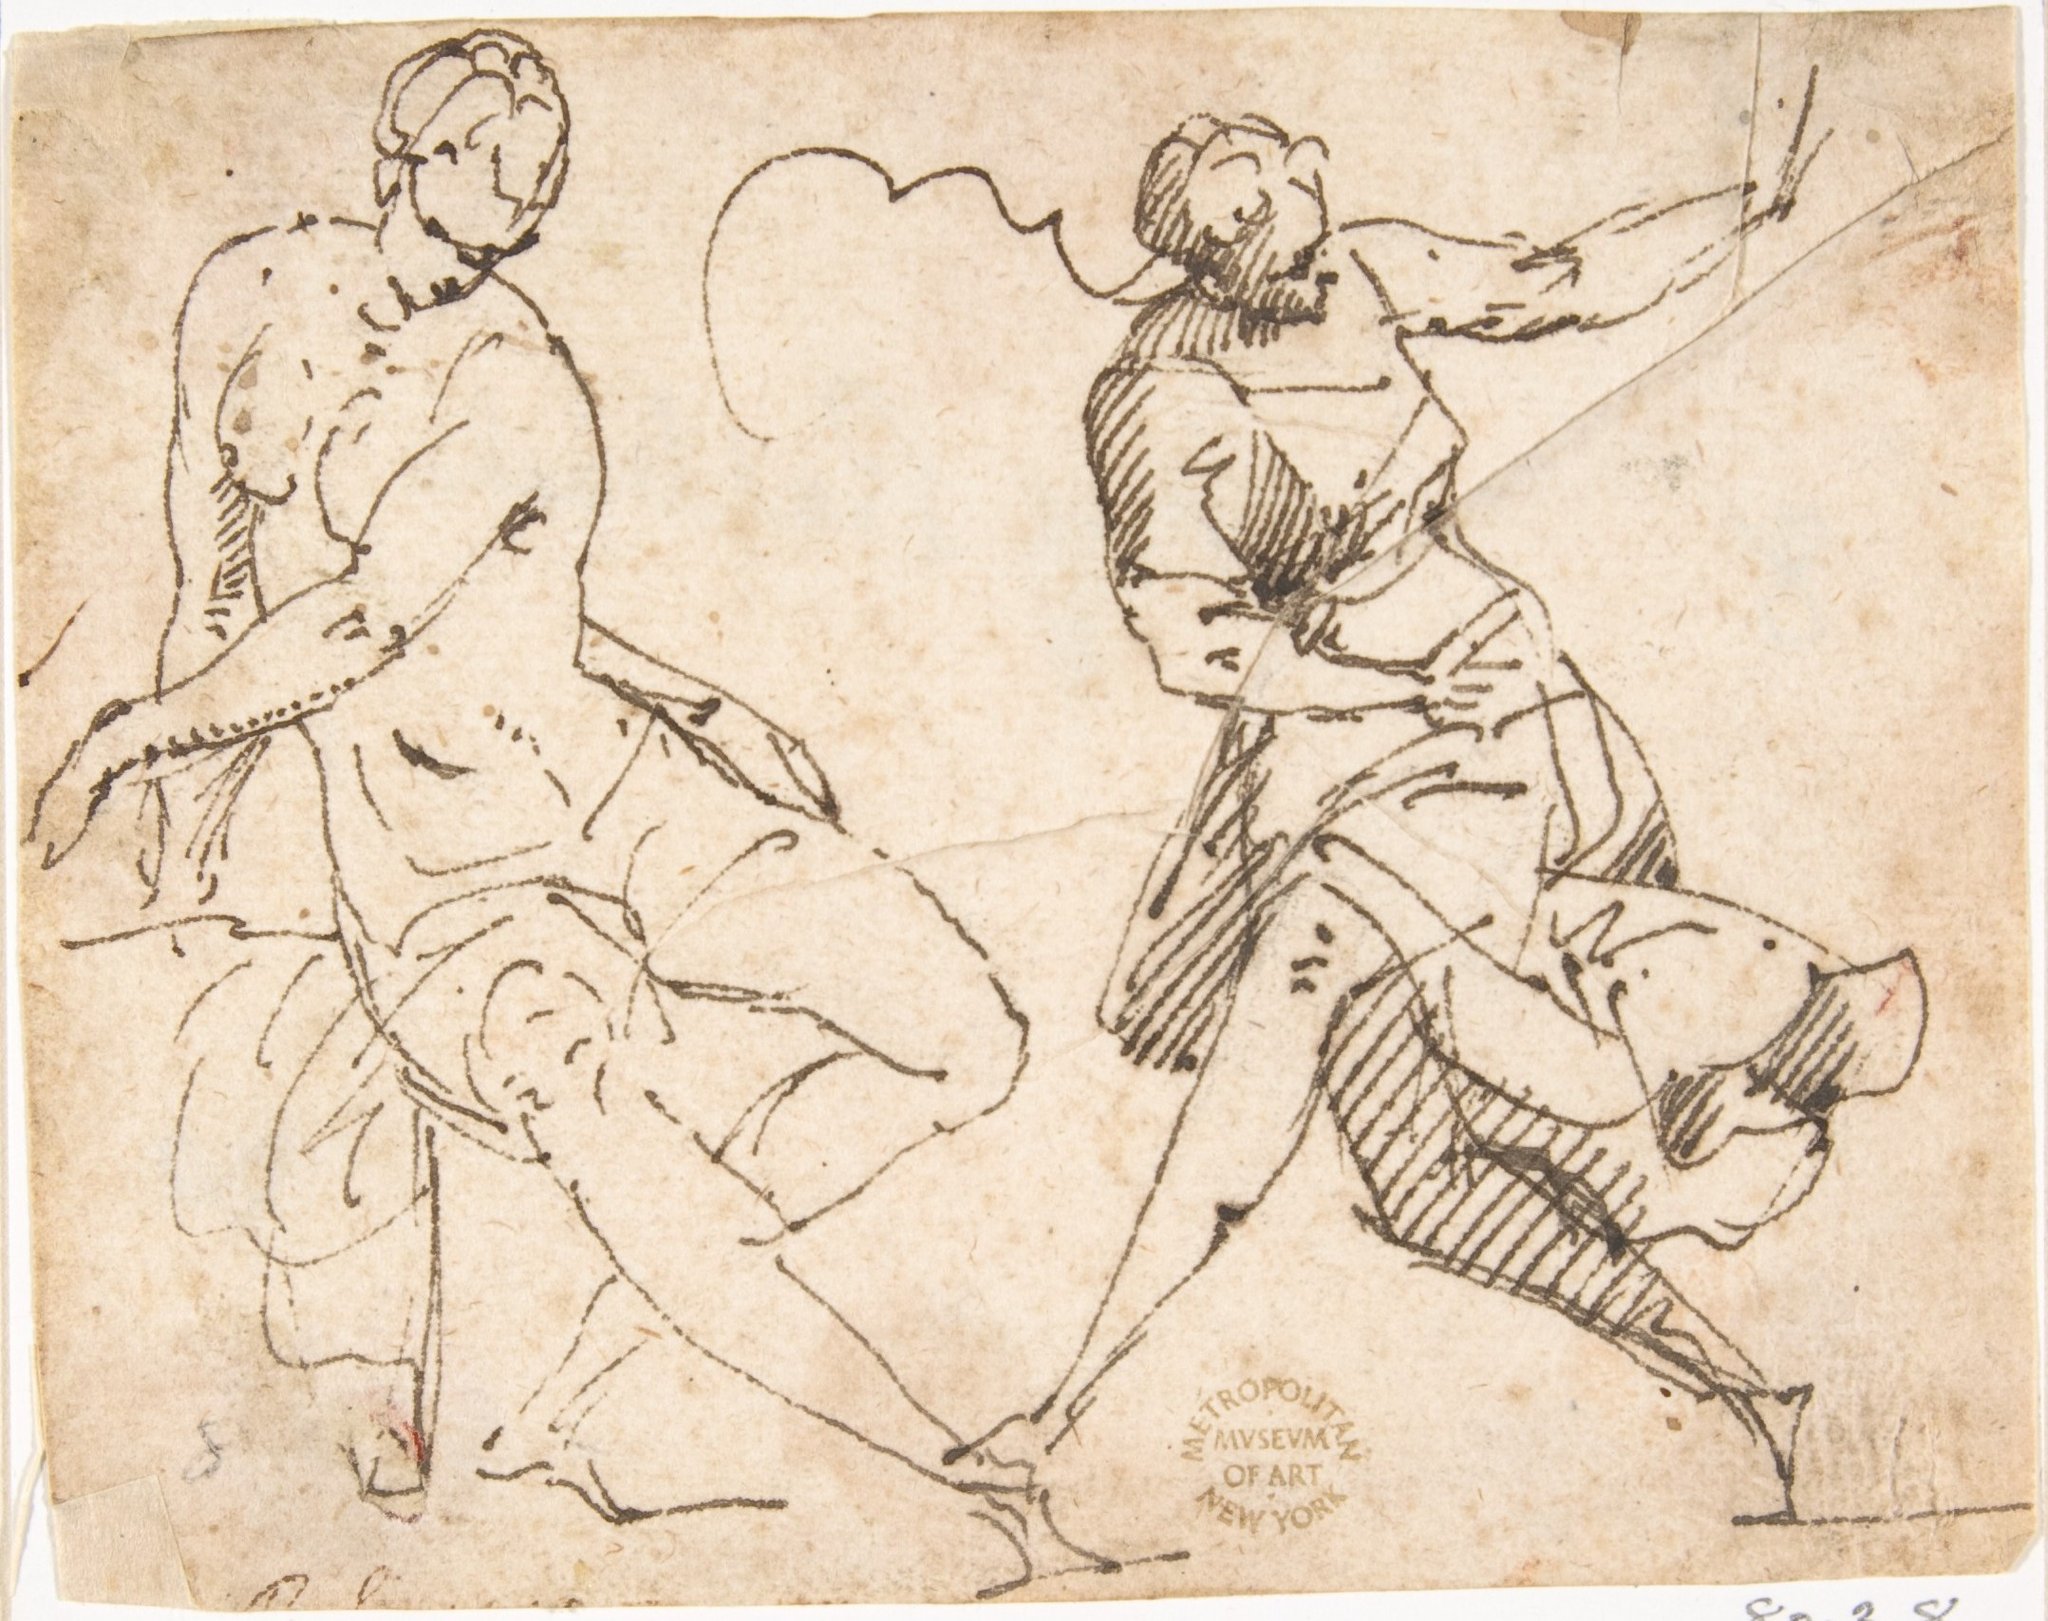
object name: drawing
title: Seated Female Nude and Dancing Female Figure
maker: francesco allegrini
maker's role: artist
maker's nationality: italian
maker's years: 1615-1679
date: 1624-1663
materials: ink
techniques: pen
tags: female nudes,dancing